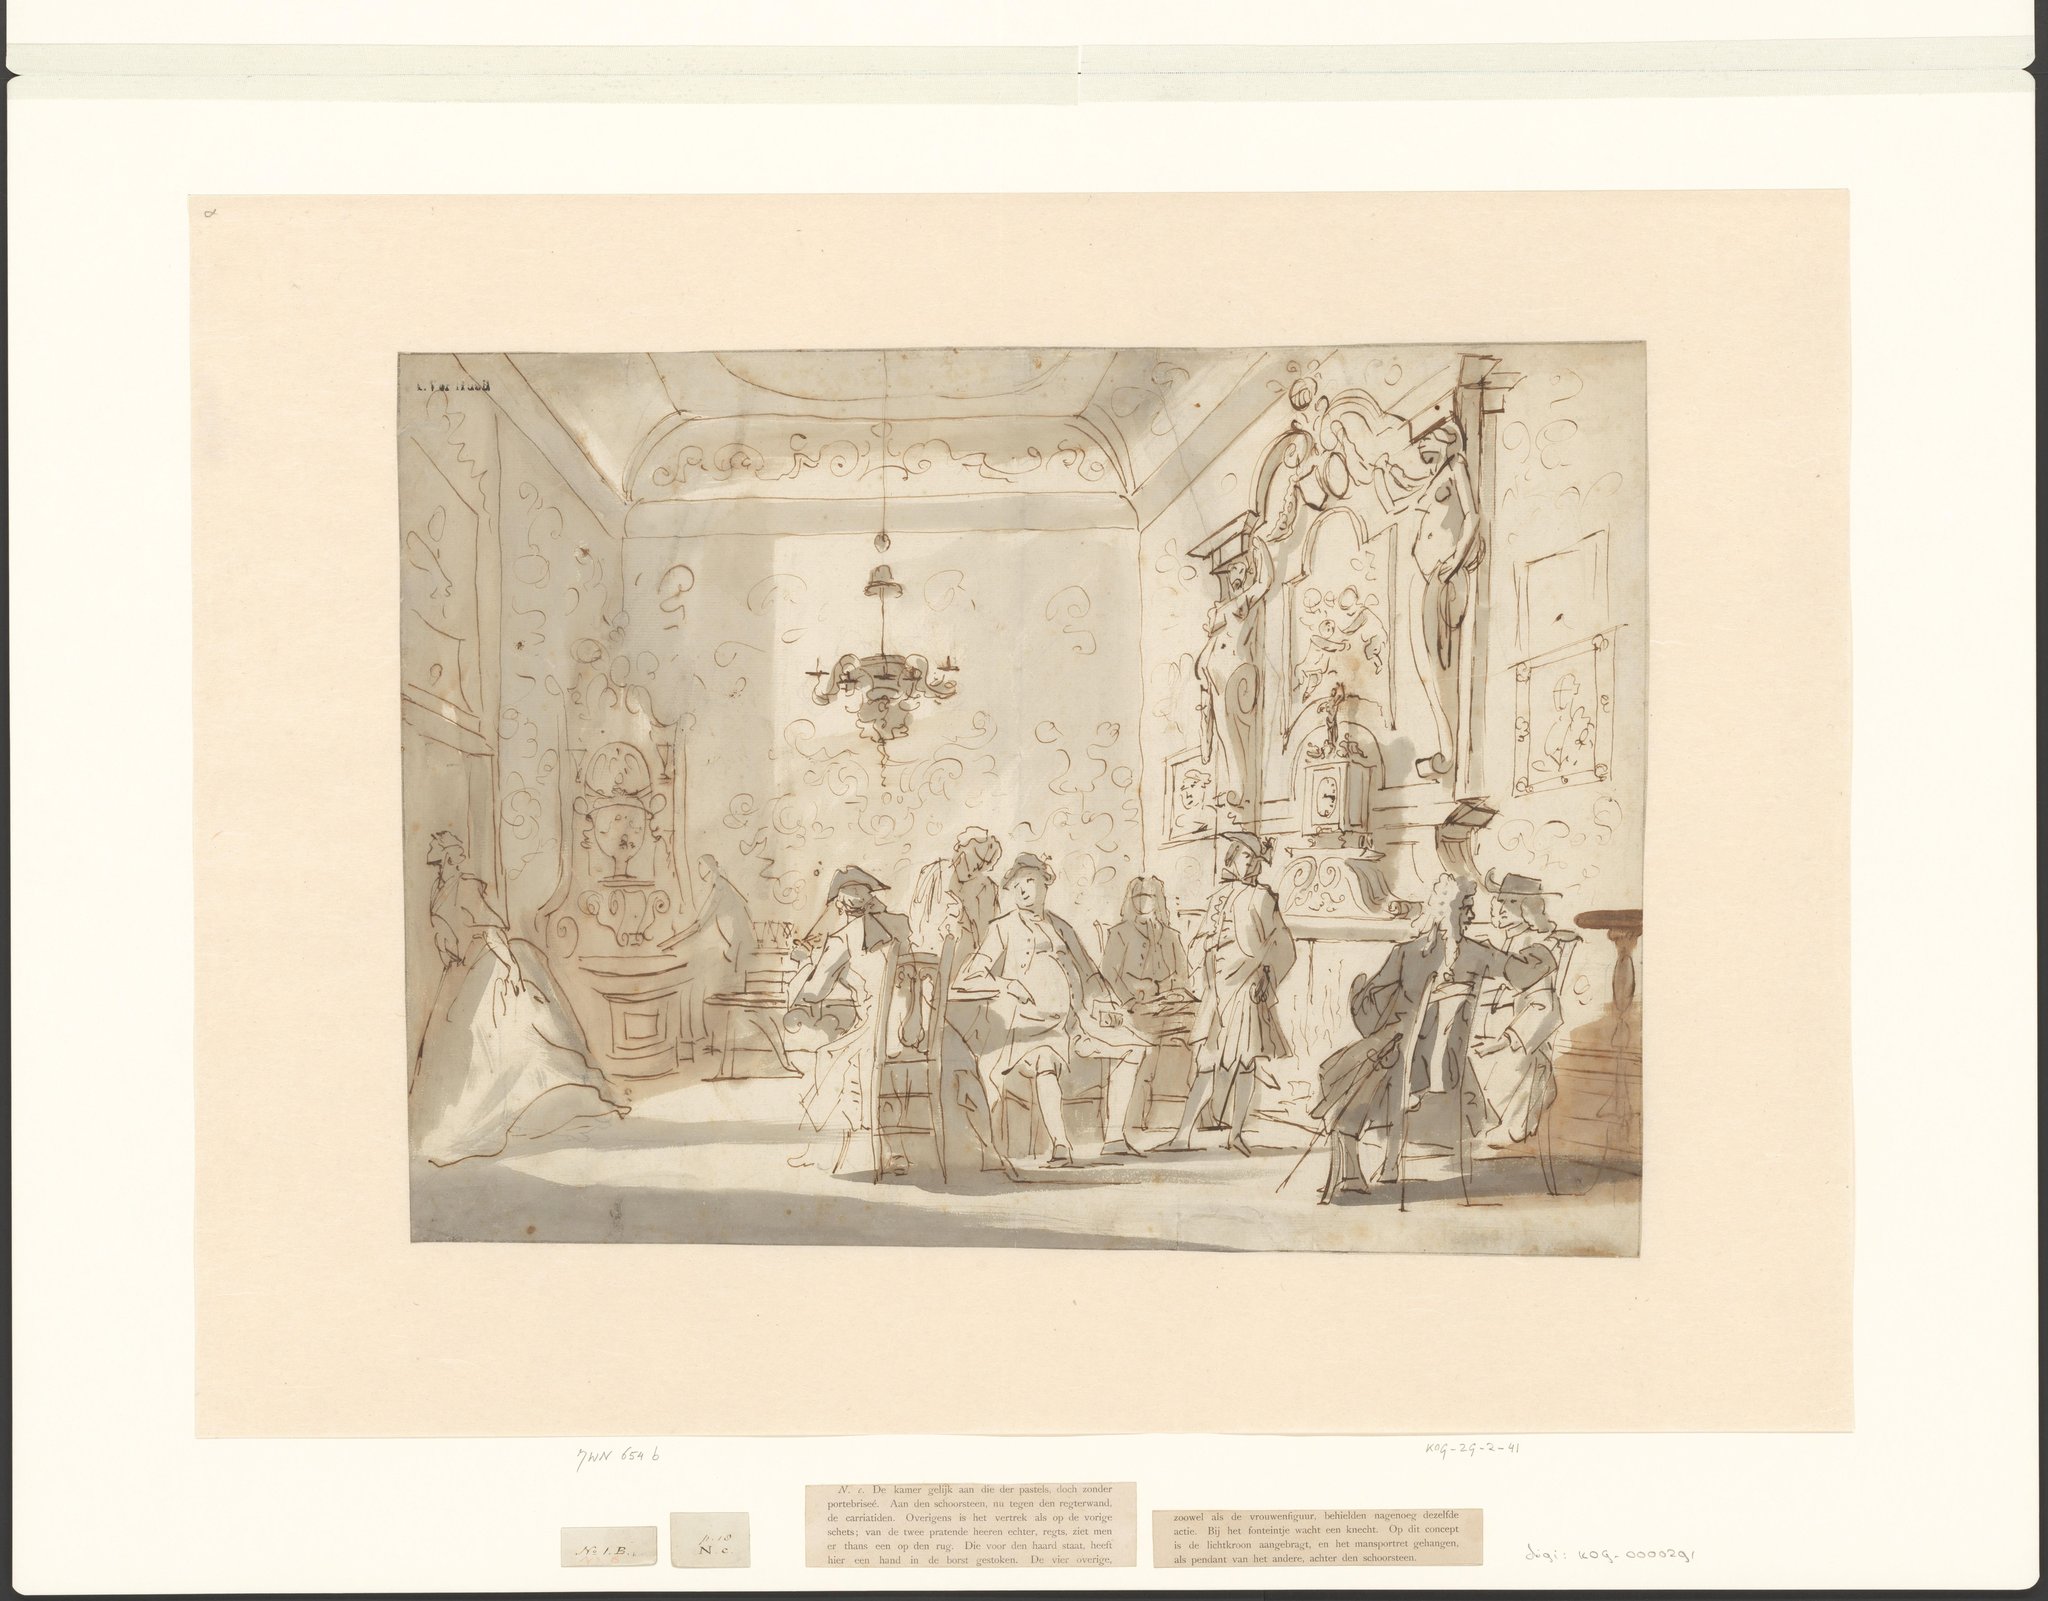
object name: drawing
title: Studie voor Nemo Loquebatur (Niemand sprak er)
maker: cornelis troost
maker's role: draughtsman, painter, print maker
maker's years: 1696-1750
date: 1739-1740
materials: ink, paper, pencil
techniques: brush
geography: netherlands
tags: criticizing and discussing art, art criticism, pipe ~ tobacco (+ taking (particular) foodstuffs: eating, drinking, smoking, chewing, etc.)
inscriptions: collector's mark: Lugt 2488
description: Samenkomst van heren in een interieur, ze zwijgen allen. Tweede voorstelling uit de Nelri-serie.